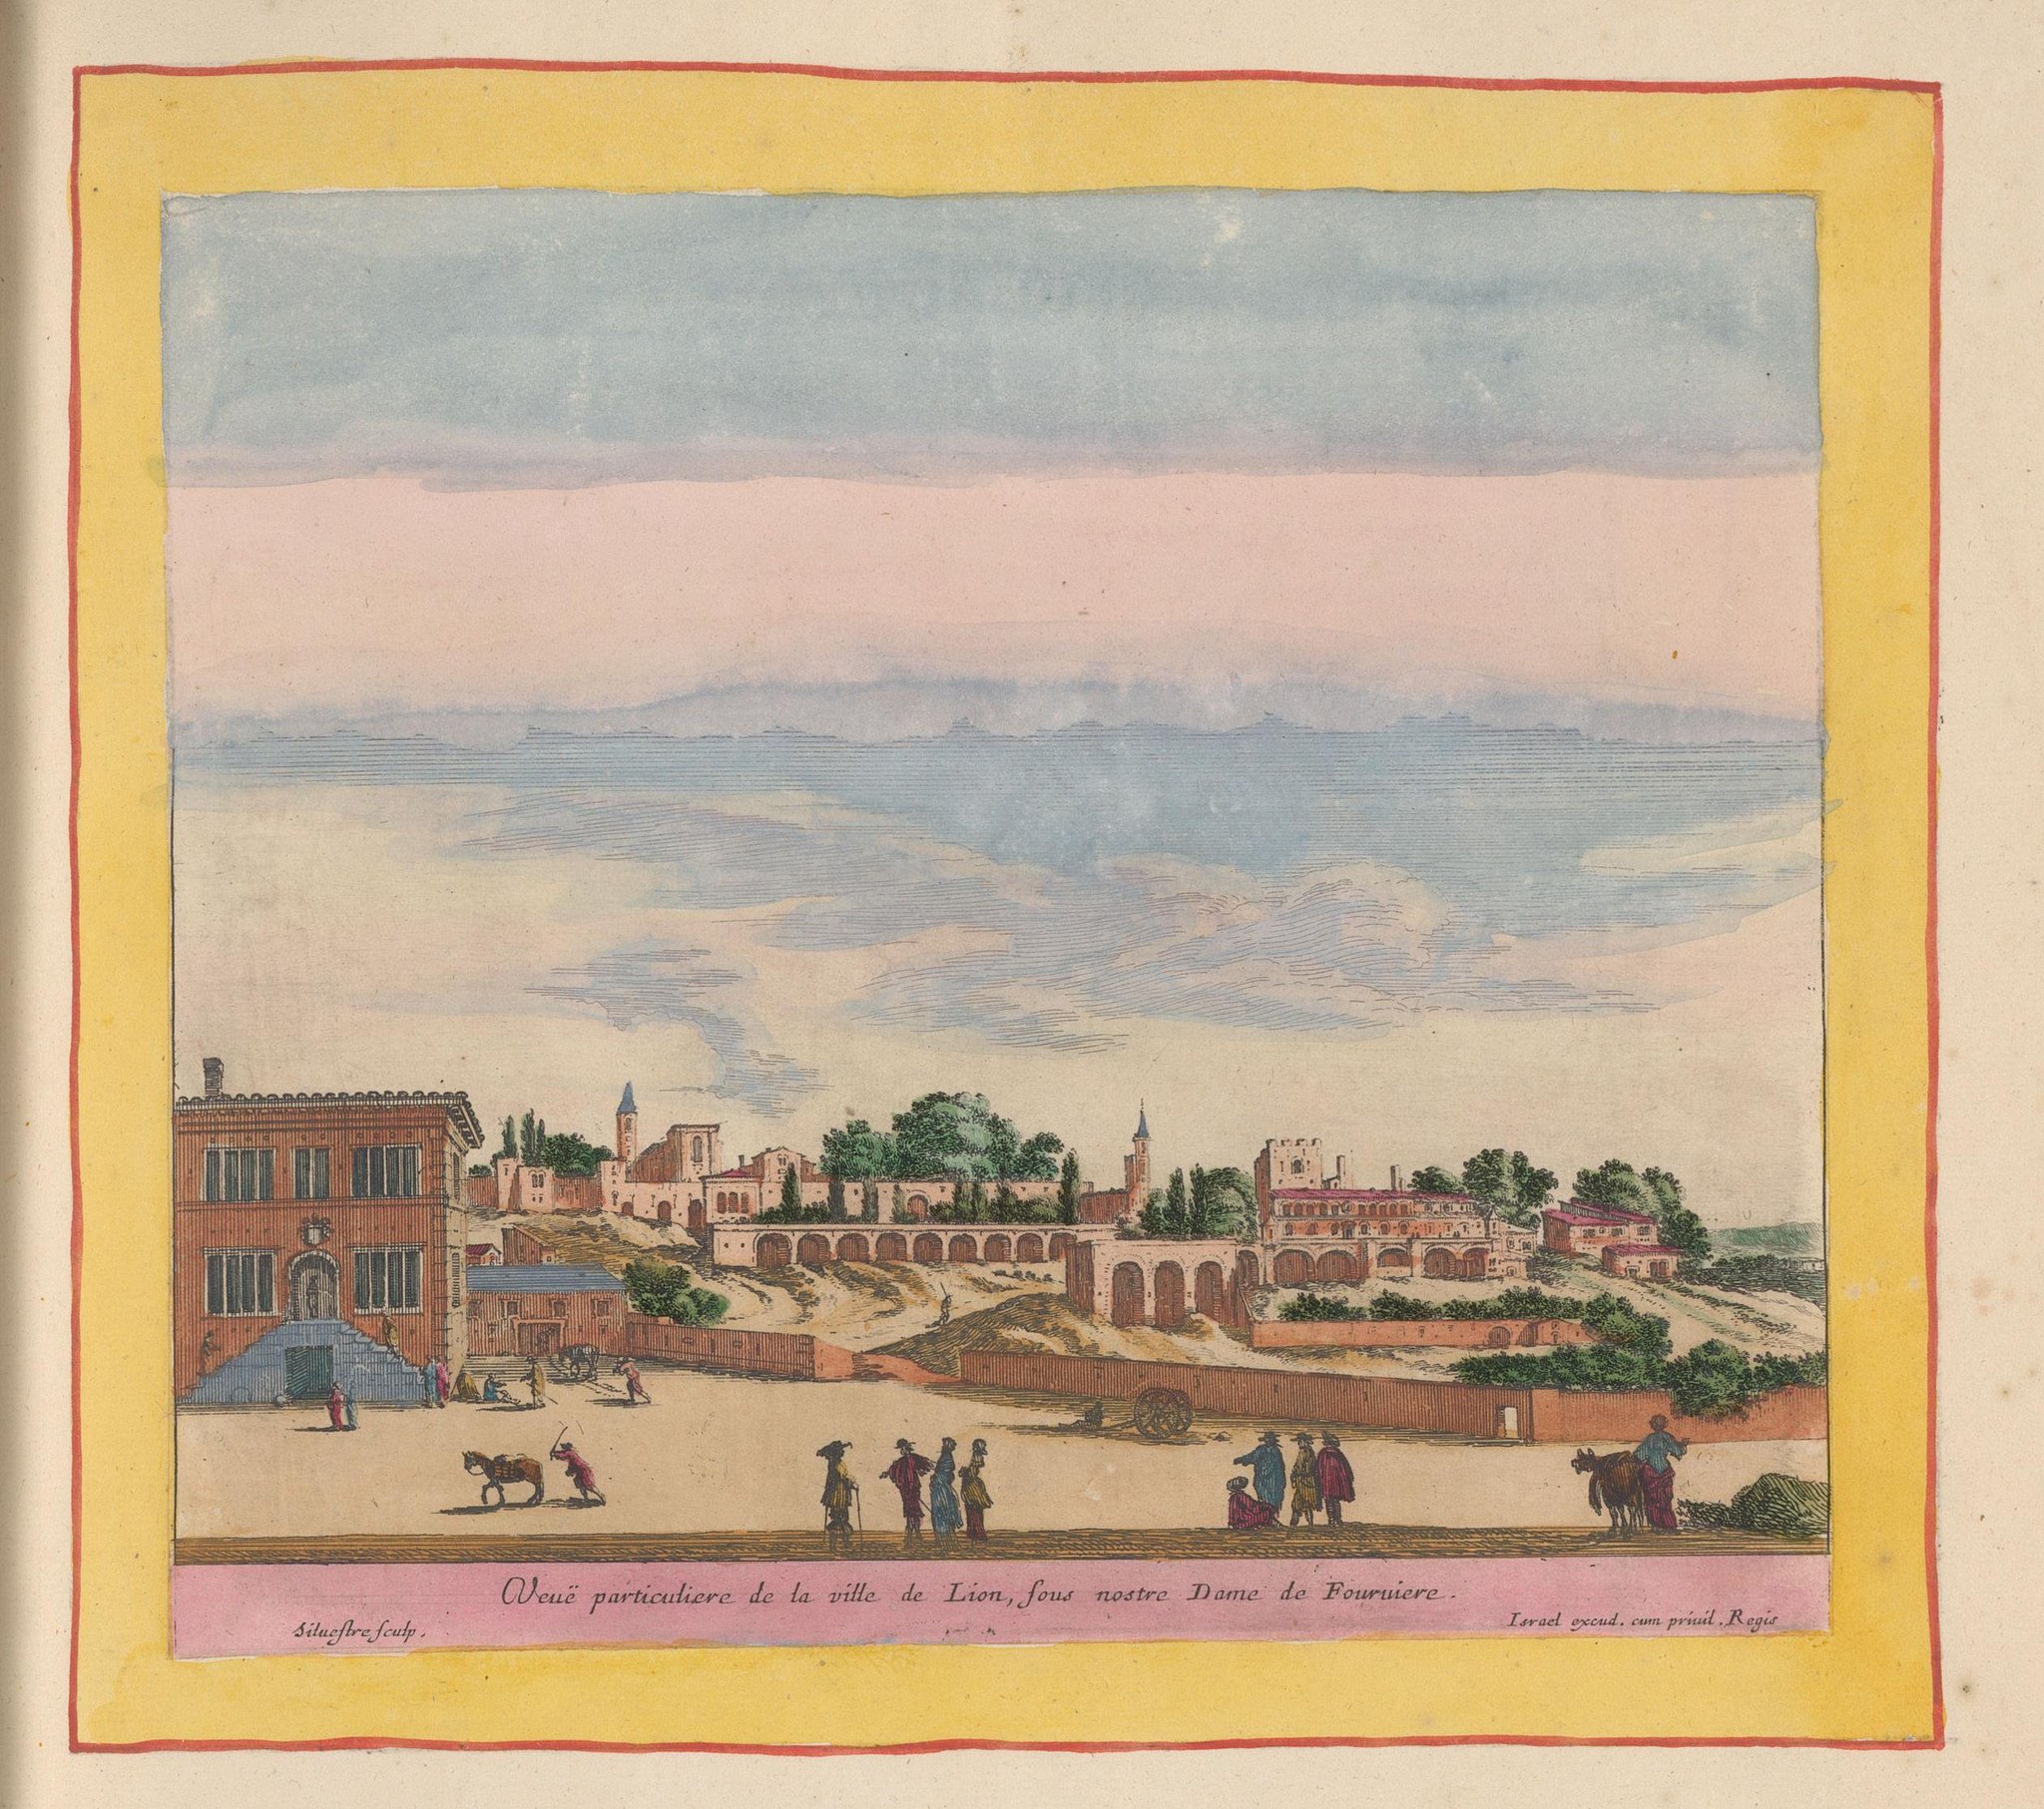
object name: print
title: Veuë particuliere de la ville de Lion, sous noste Dame de Fourviere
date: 1631-1661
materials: paper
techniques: etching, hand coloring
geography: paris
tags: city-view in general; 'veduta', lyon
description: Deze prent maakt deel uit van een album.